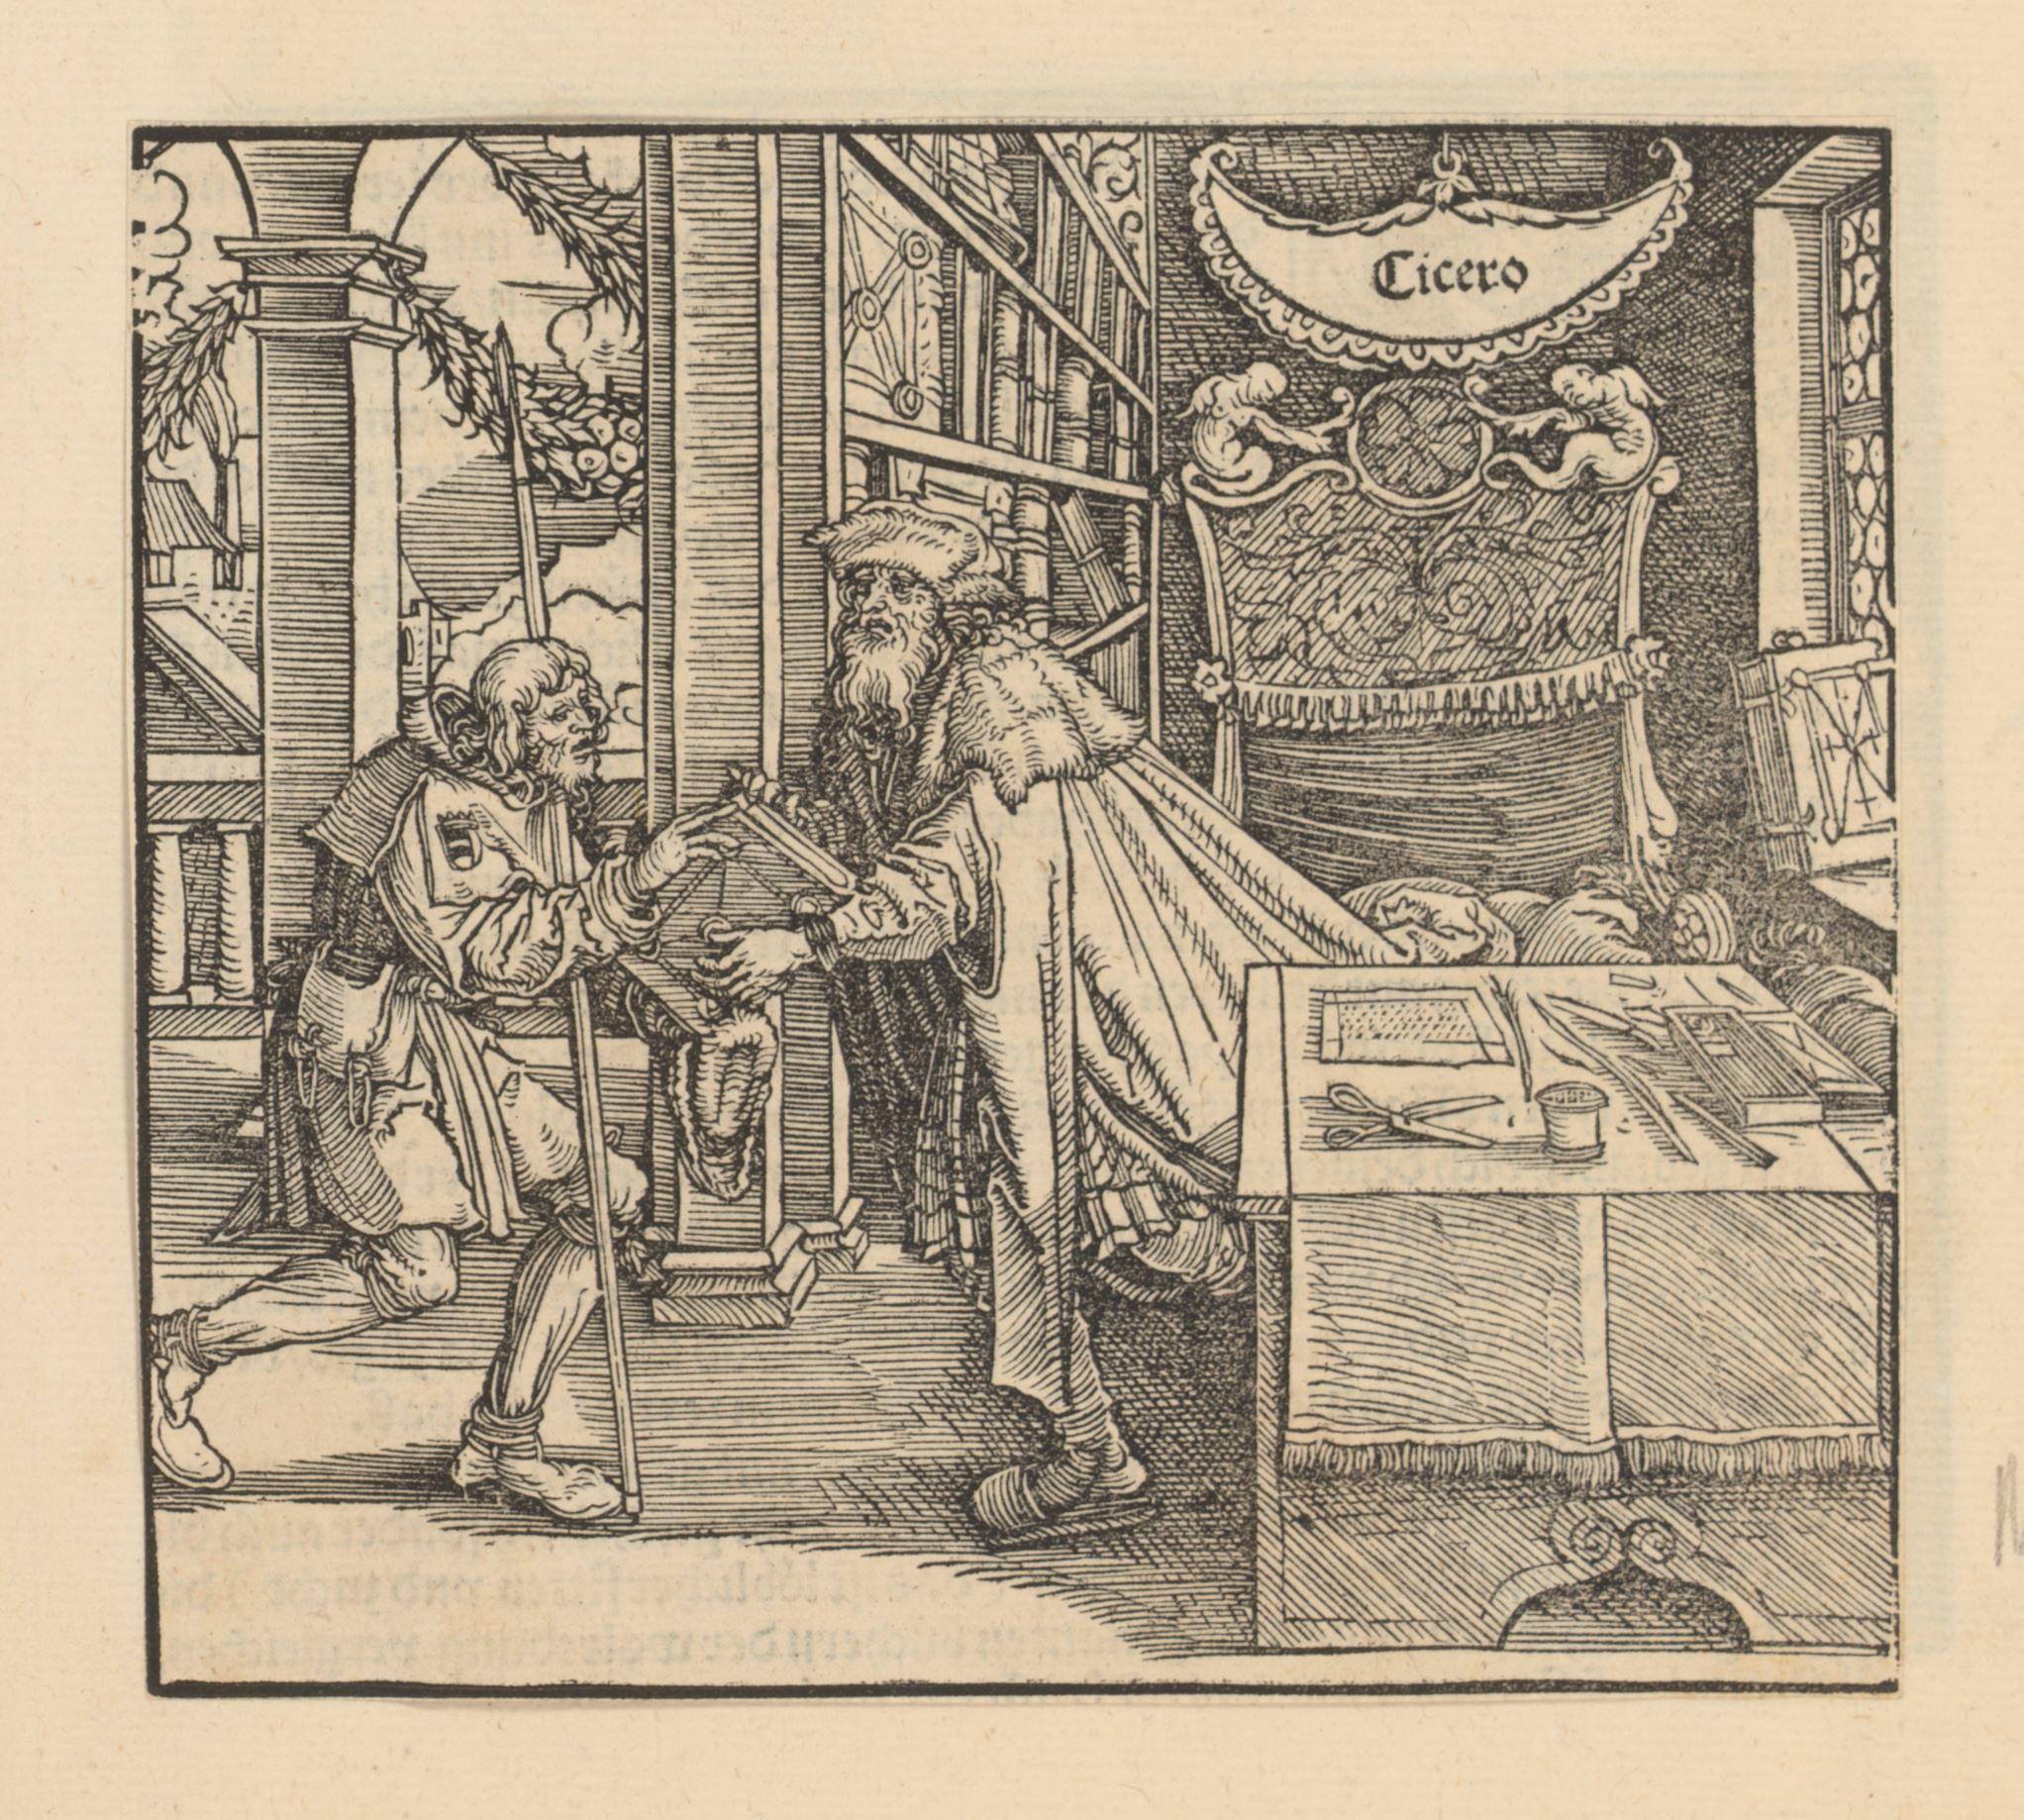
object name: print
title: Cicero overhandigt een boek aan een bode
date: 1514-1531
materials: paper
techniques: letterpress printing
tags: (story of) cicero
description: Deze prent is gebruikt in: Cicero, Marcus Tulius. Officia M.T.C. Ein Buch so Marcus Tullius Cicero der Römer zu seynem (...). [Vertaald uit het Latijn door] Johann von Schwarzenberg. Augsburg: Heinrich Steiner, 1531.